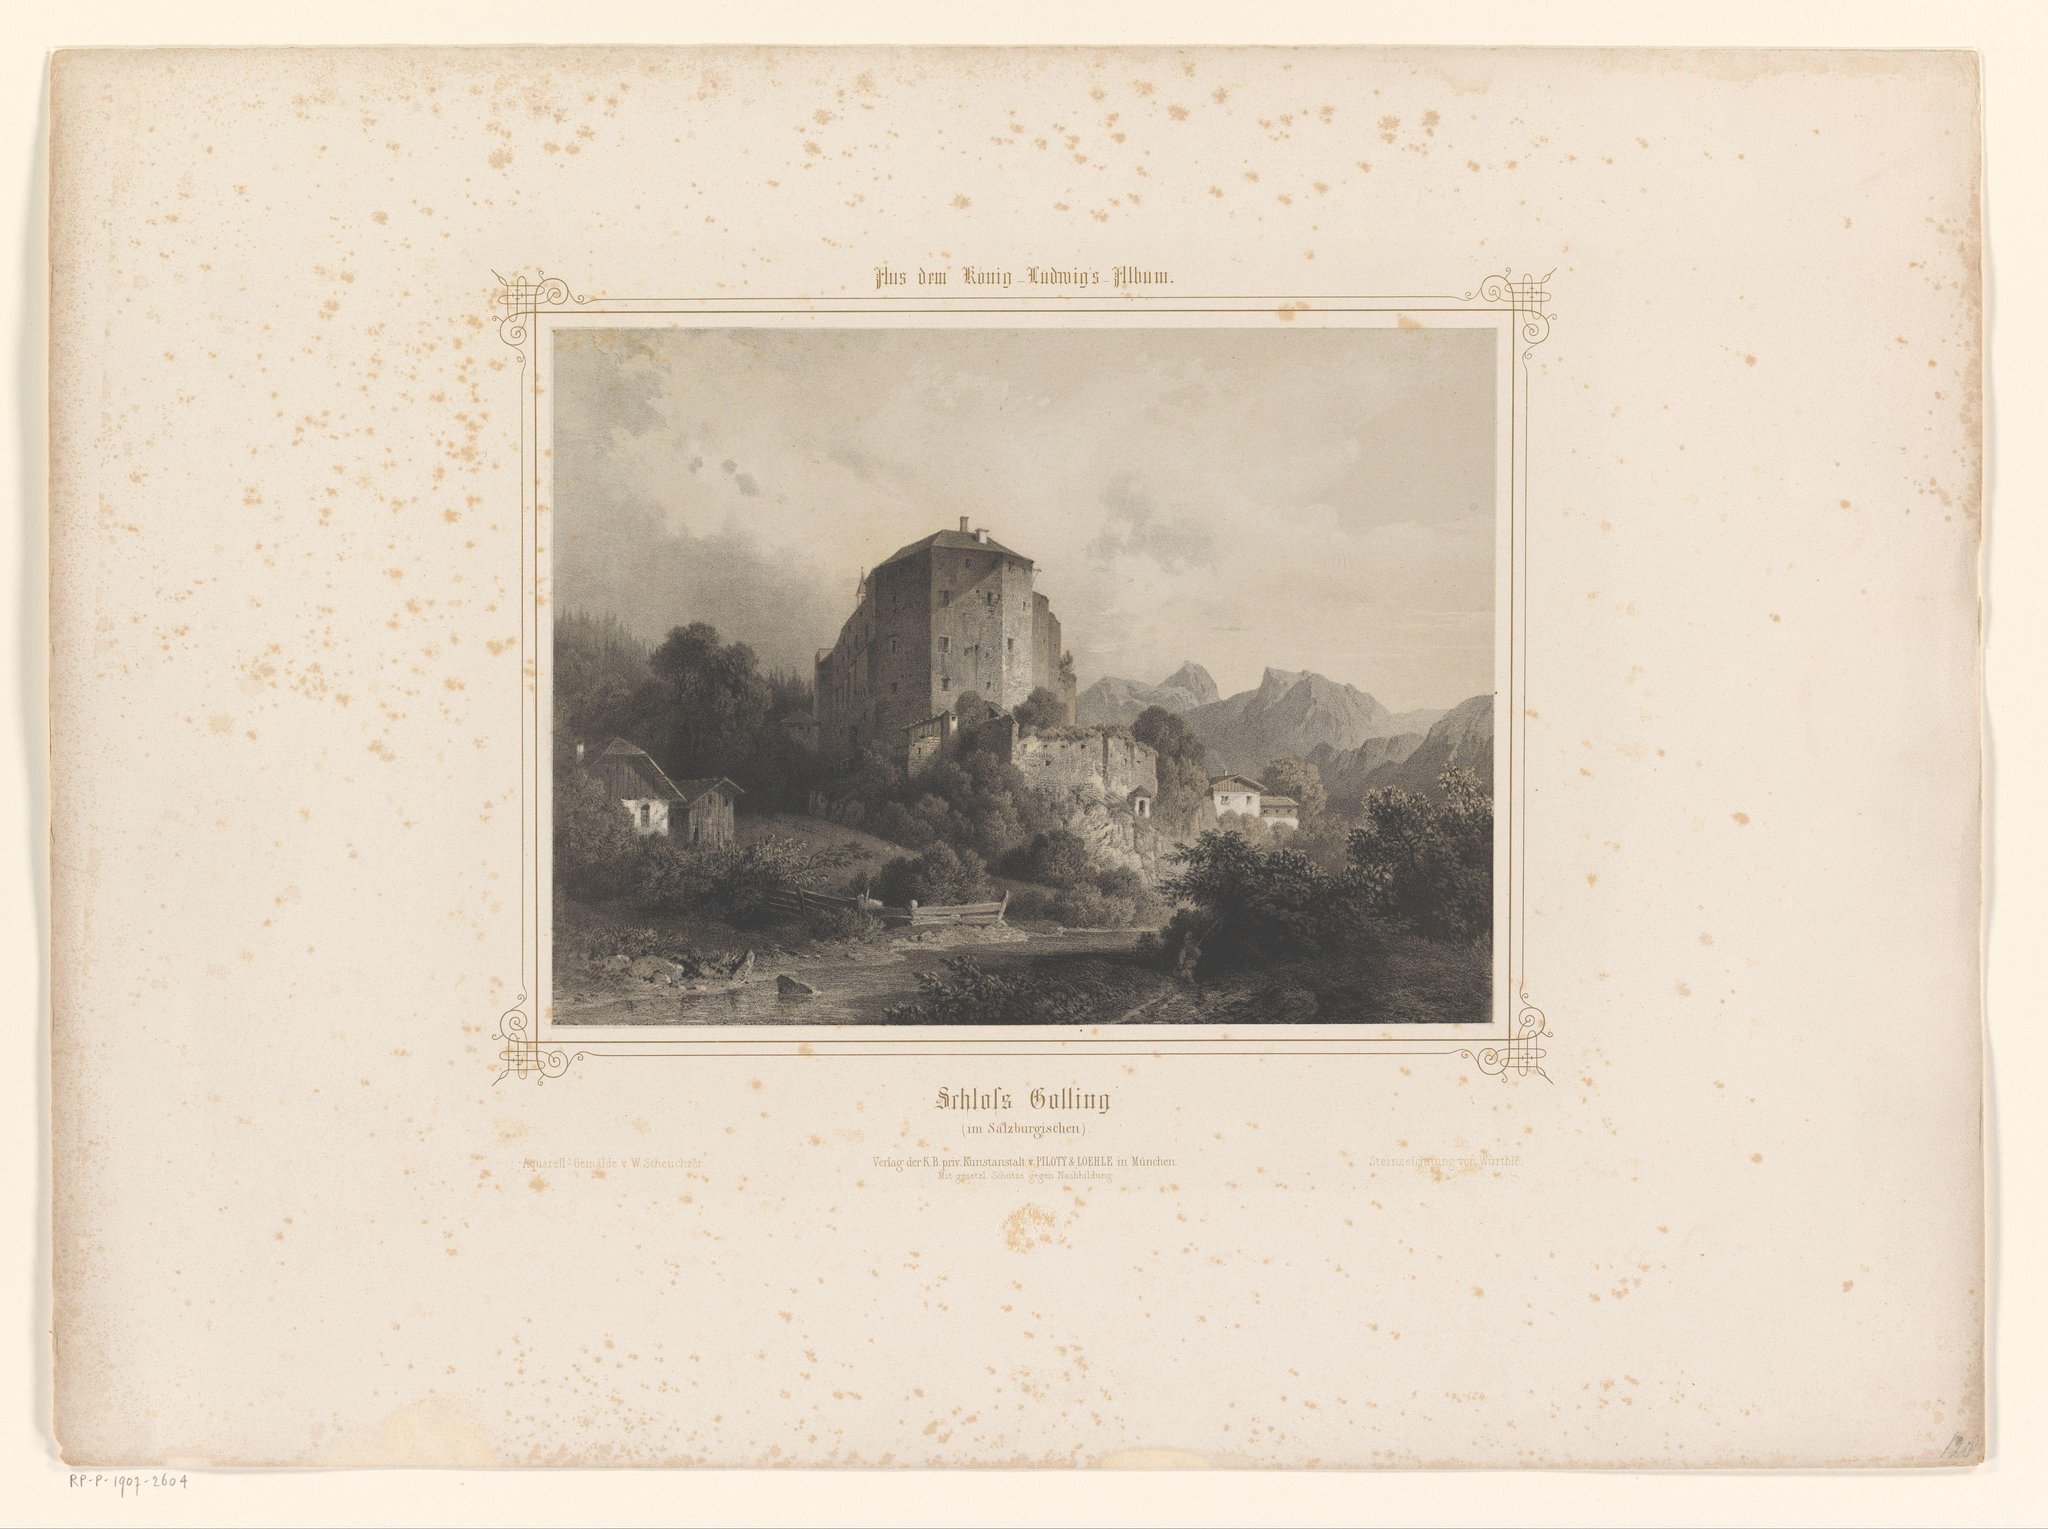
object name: print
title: Gezicht op burg Golling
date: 1850-1859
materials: paper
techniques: tone lithography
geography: munich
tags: landscapes with waters, waterscapes, seascapes (in the temperate zone), landscape with tower or castle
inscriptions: collector's mark: Lugt 2228, : ‘Mit gesetzl Schutze gegen Nachbildung’, check stamp: ‘Piloty&Loehle, München’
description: Prent afkomstig uit de serie 'Album Seiner Majestät des Königs Ludwig I. von Bayern', verschenen in verschillende afleveringen. De prenten gaan terug op het album dat Lodewijk I van Beieren op 9 oktober 1850 kreeg overhandigd van verschillende kunstenaars.